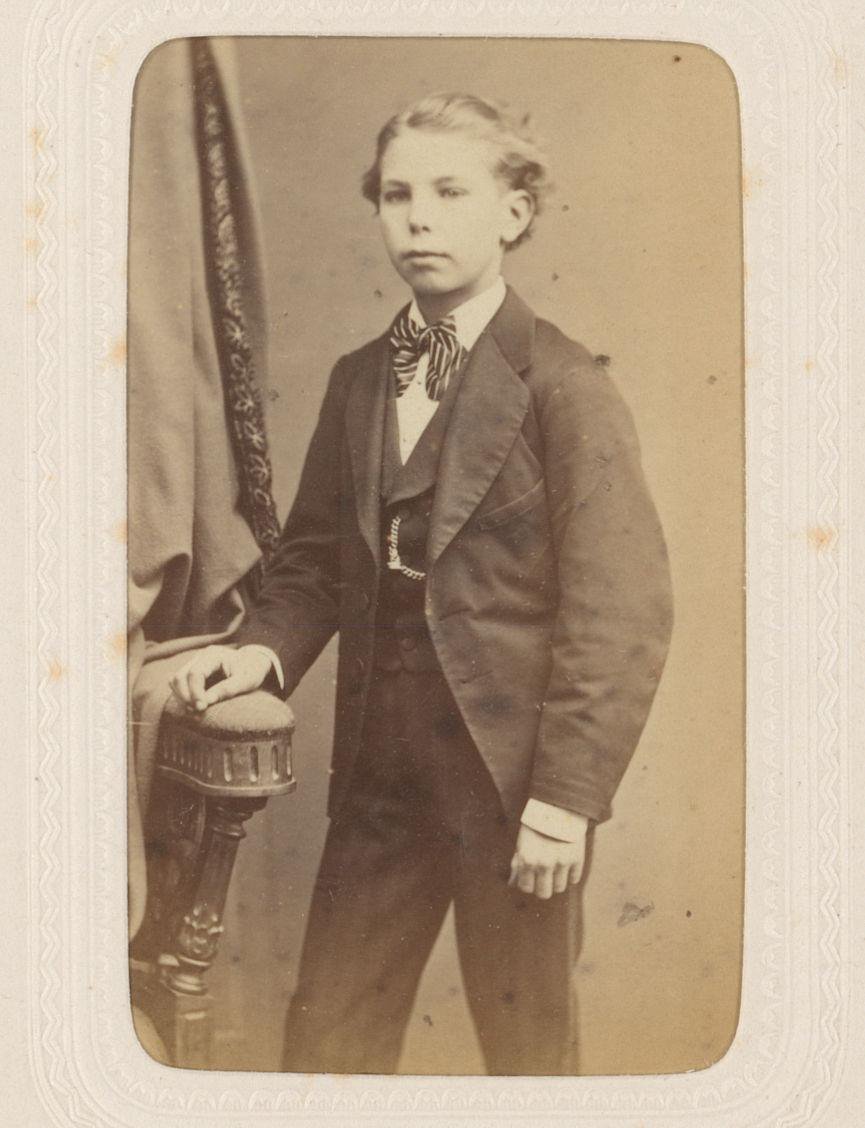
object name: carte de visite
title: Studioportret van een jongen gekleed in driedelig kostuum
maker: albert greiner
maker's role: fotograaf, fotostudio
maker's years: 1833-1890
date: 1863-1866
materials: cardboard, paper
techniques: albumen print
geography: amsterdam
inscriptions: name: ‘Albert Greiner Amsterdam’